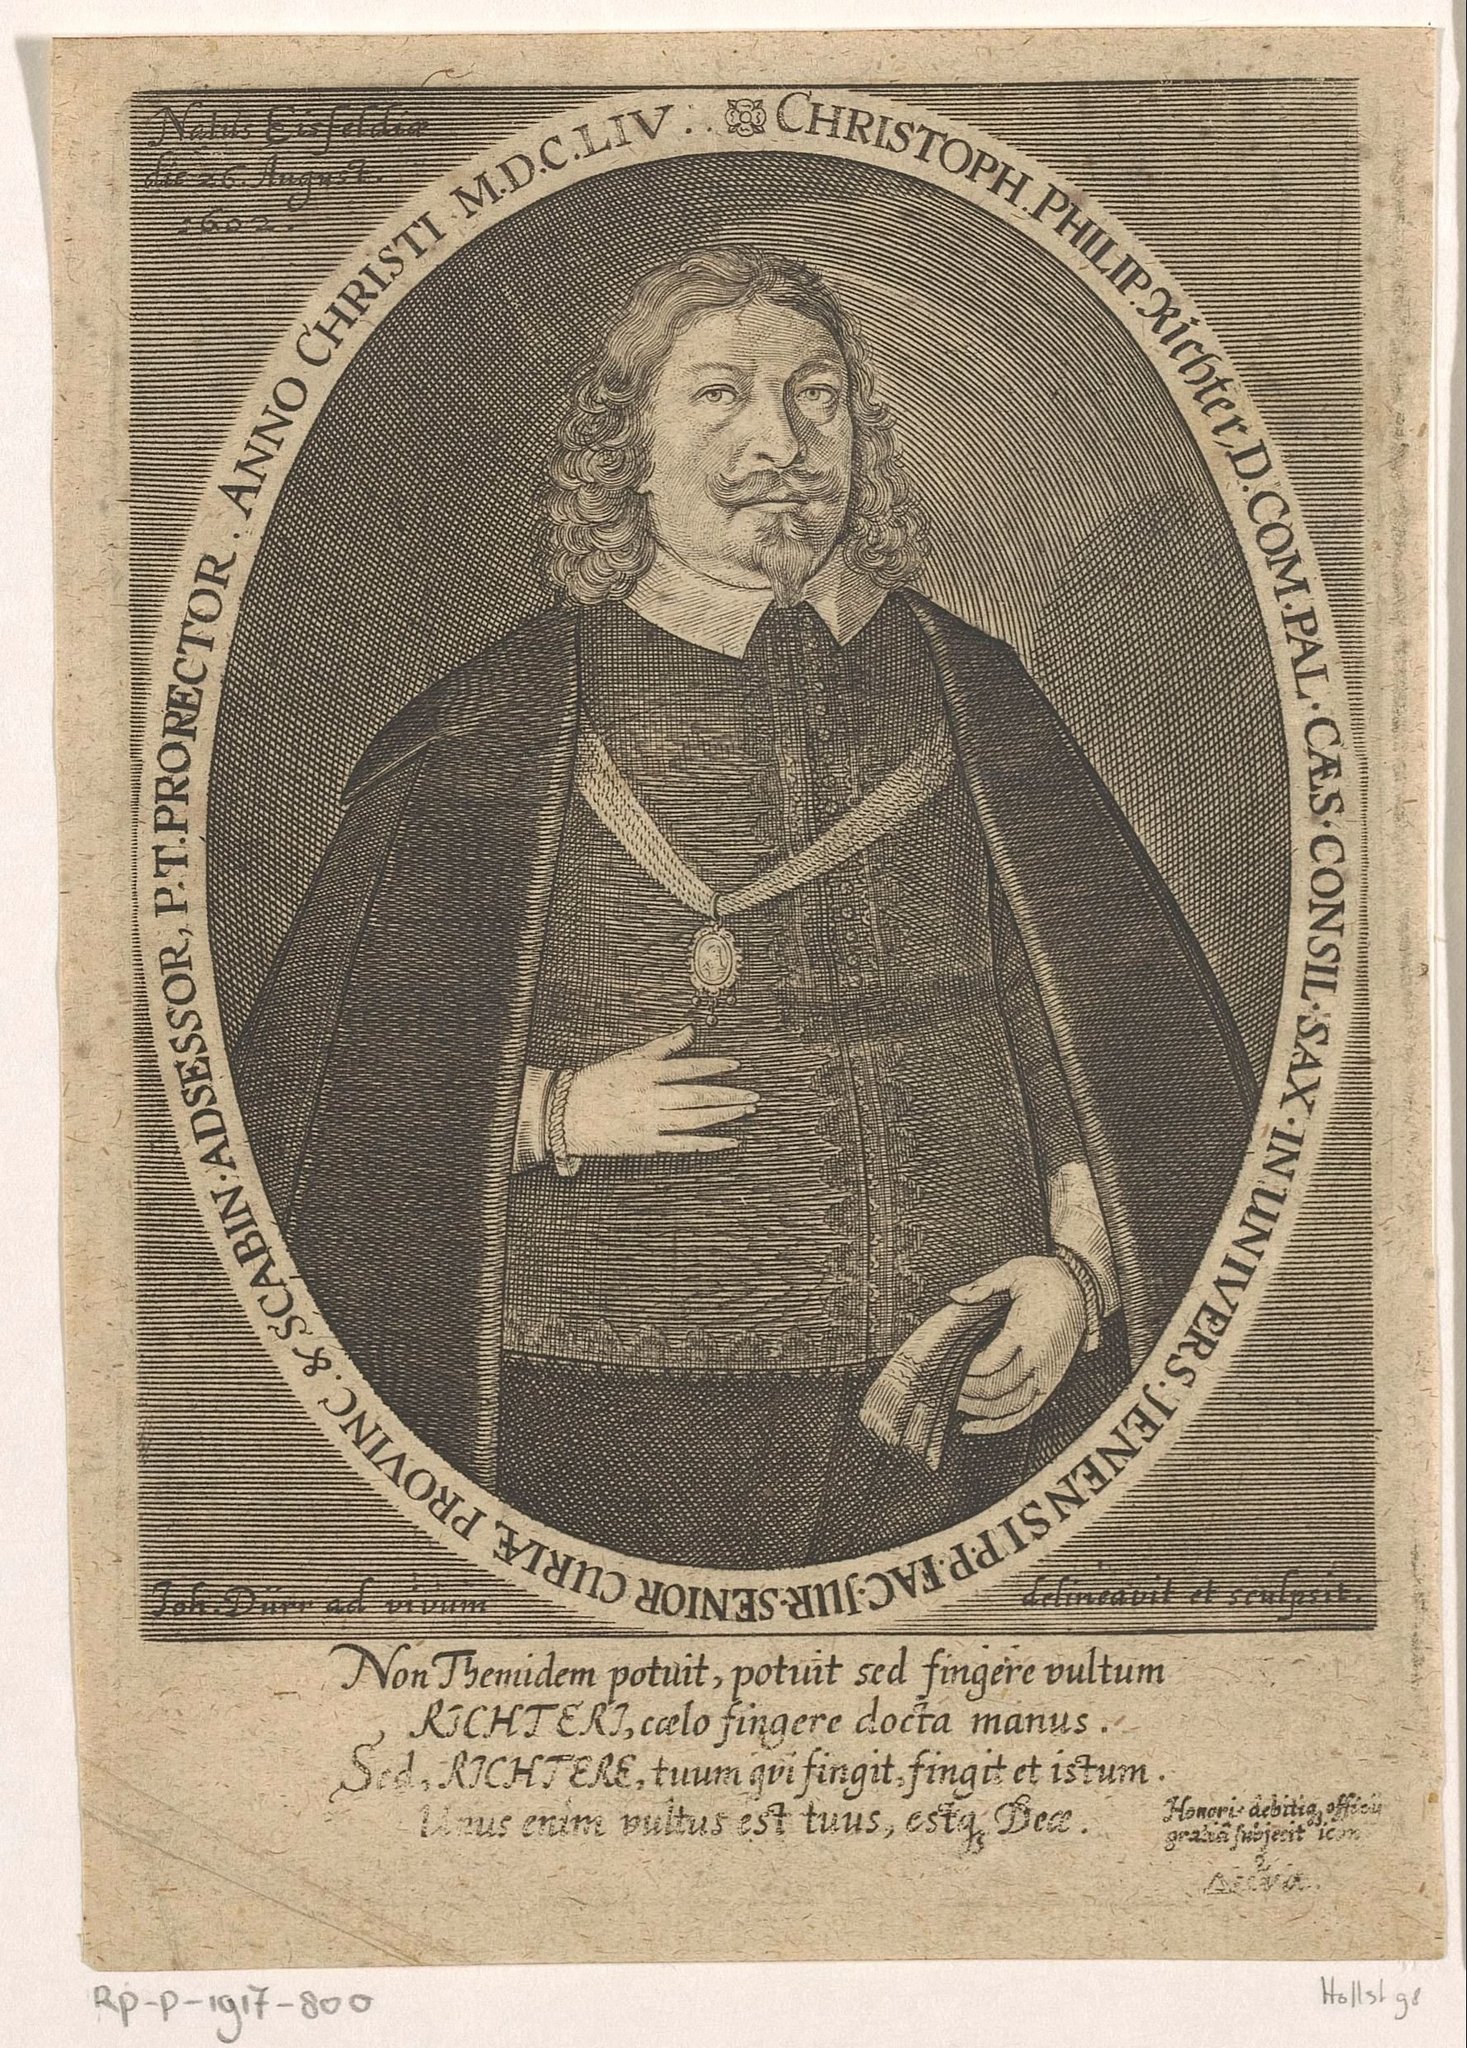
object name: print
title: Portret van Christoph Philipp Richter op 52-jarige leeftijd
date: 1654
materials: paper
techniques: engraving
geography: germany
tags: historical persons, pendant, trinket, 'breloque'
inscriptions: collector's mark: Lugt 2228